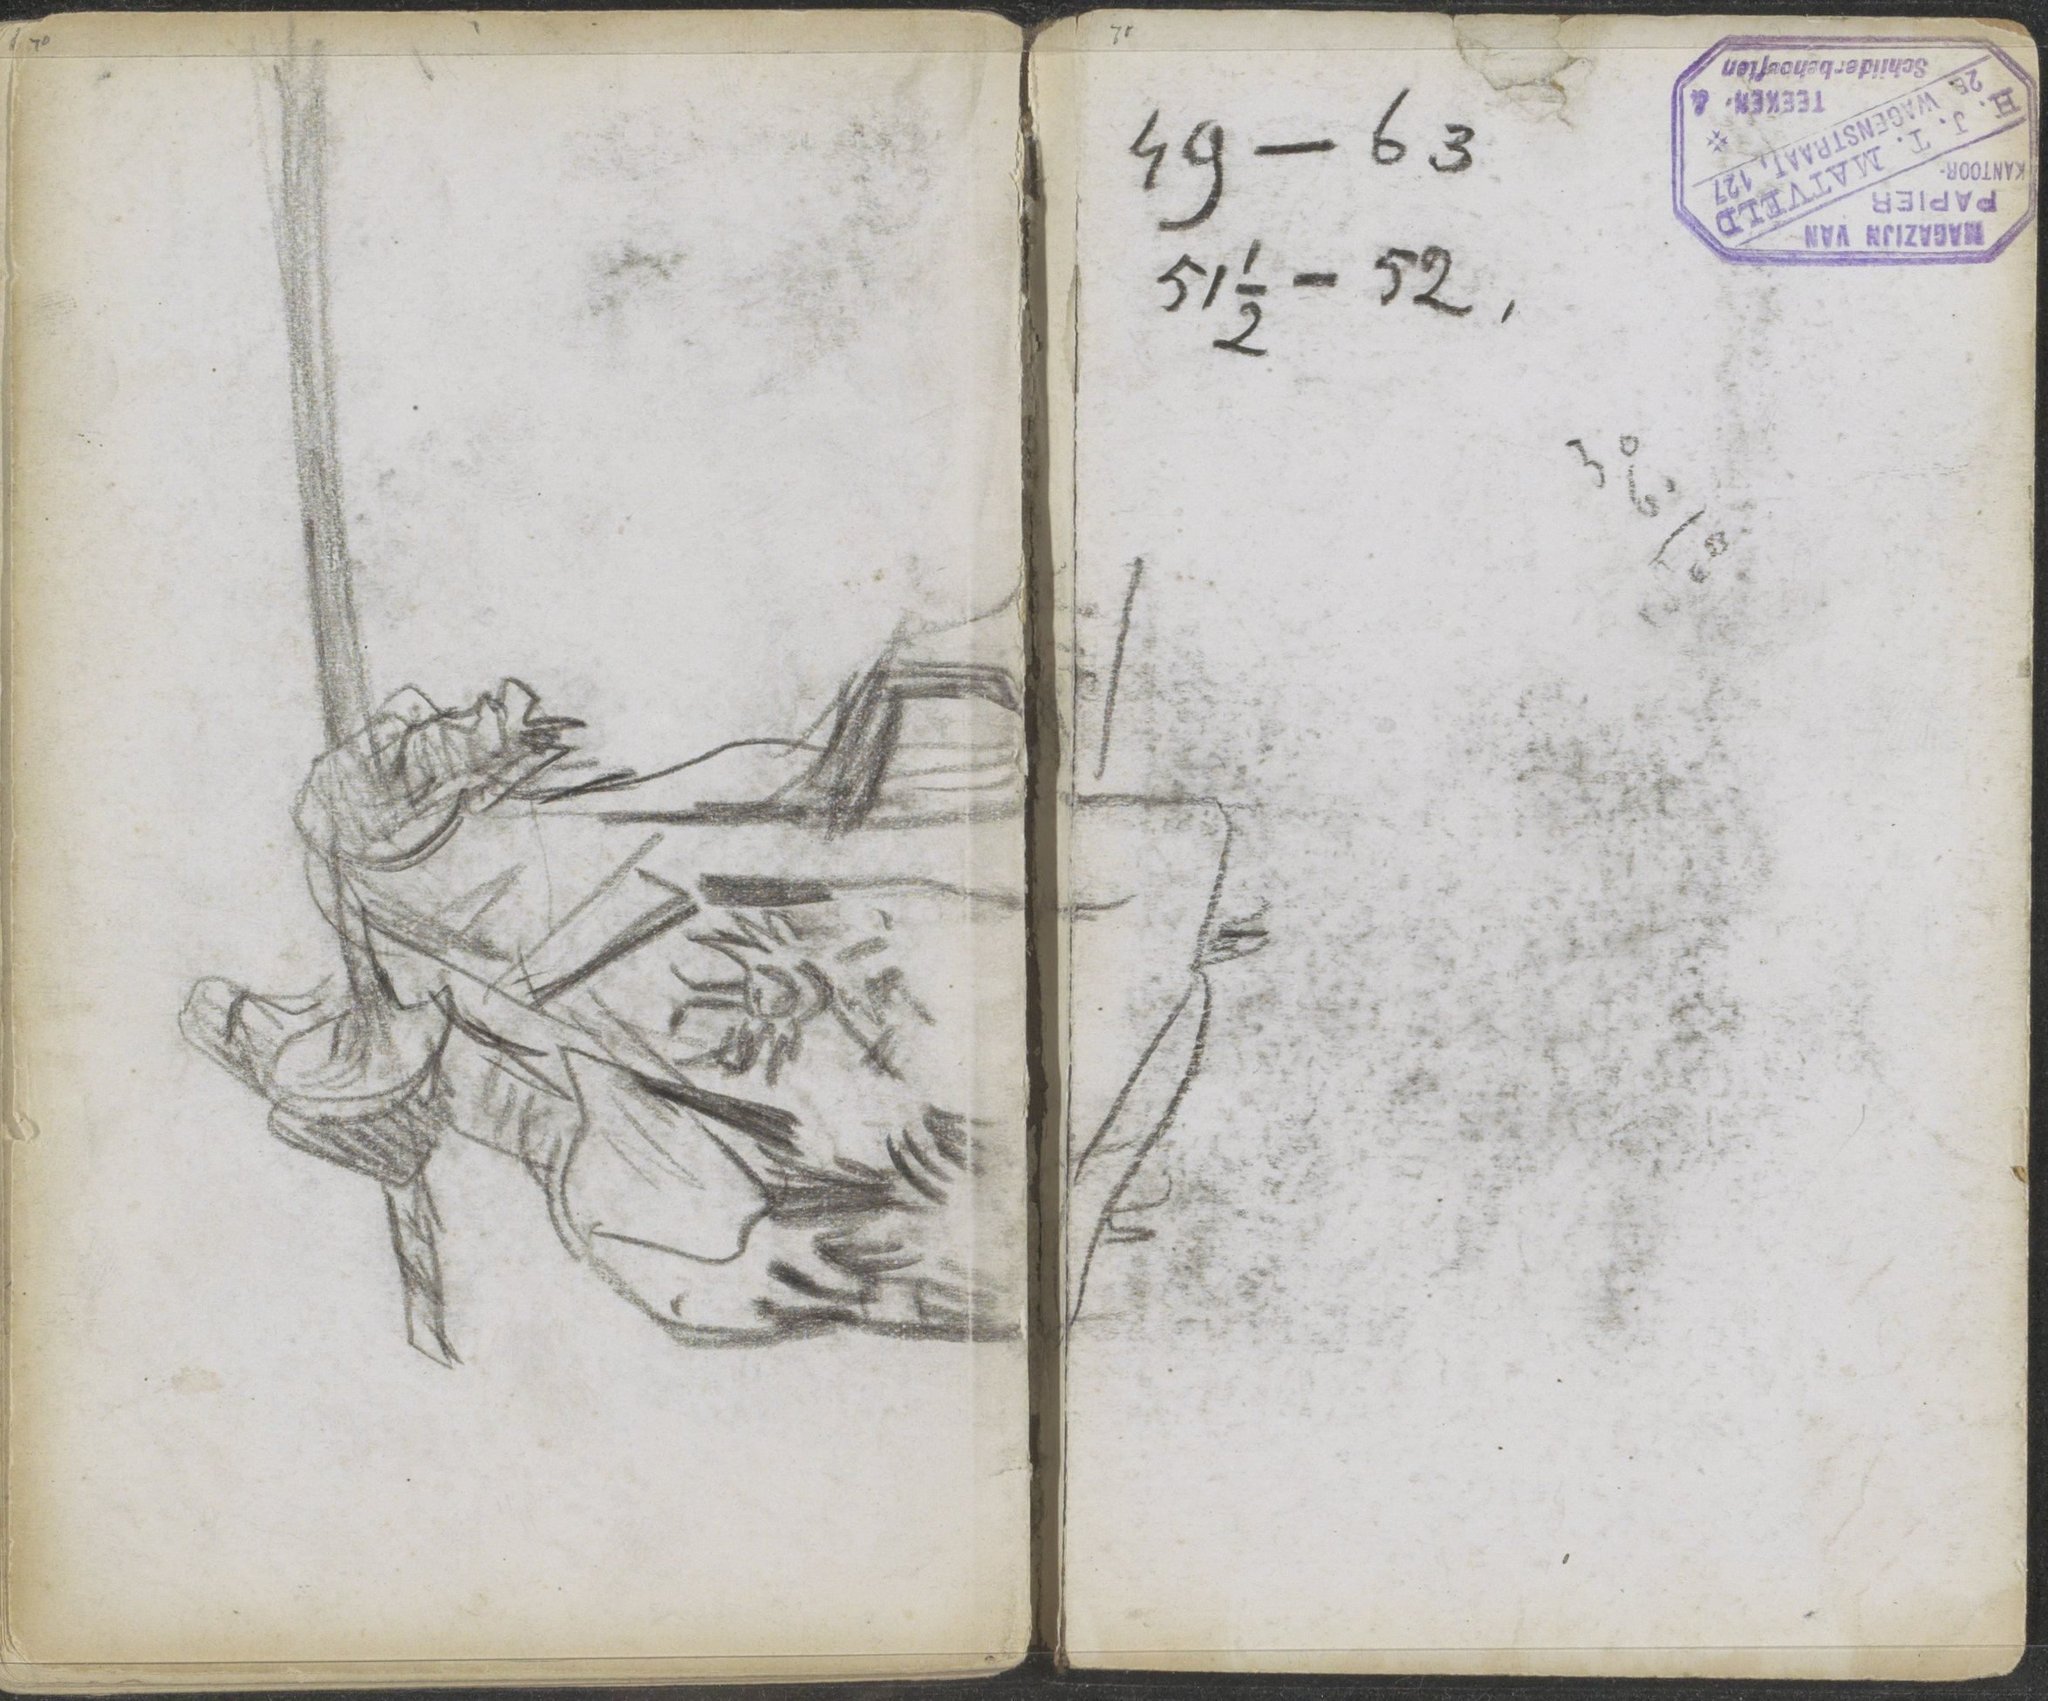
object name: sketchbook leaf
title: Ridder te paard in harnas uit het Musée des Invalides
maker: marius bauer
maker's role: draughtsman, print maker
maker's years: 1867-1932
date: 1810-1891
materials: chalk, paper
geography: paris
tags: helmet, riding a horse, ass, or mule; rider, horseman, armour, knight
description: Bauer tekende naar de beelden van ridders in harnas die tentoongesteld waren in het museum, dat gewijd is aan de militaire geschiedenis van Frankrijk. Pagina 70 uit een schetsboek met 35 bladen.